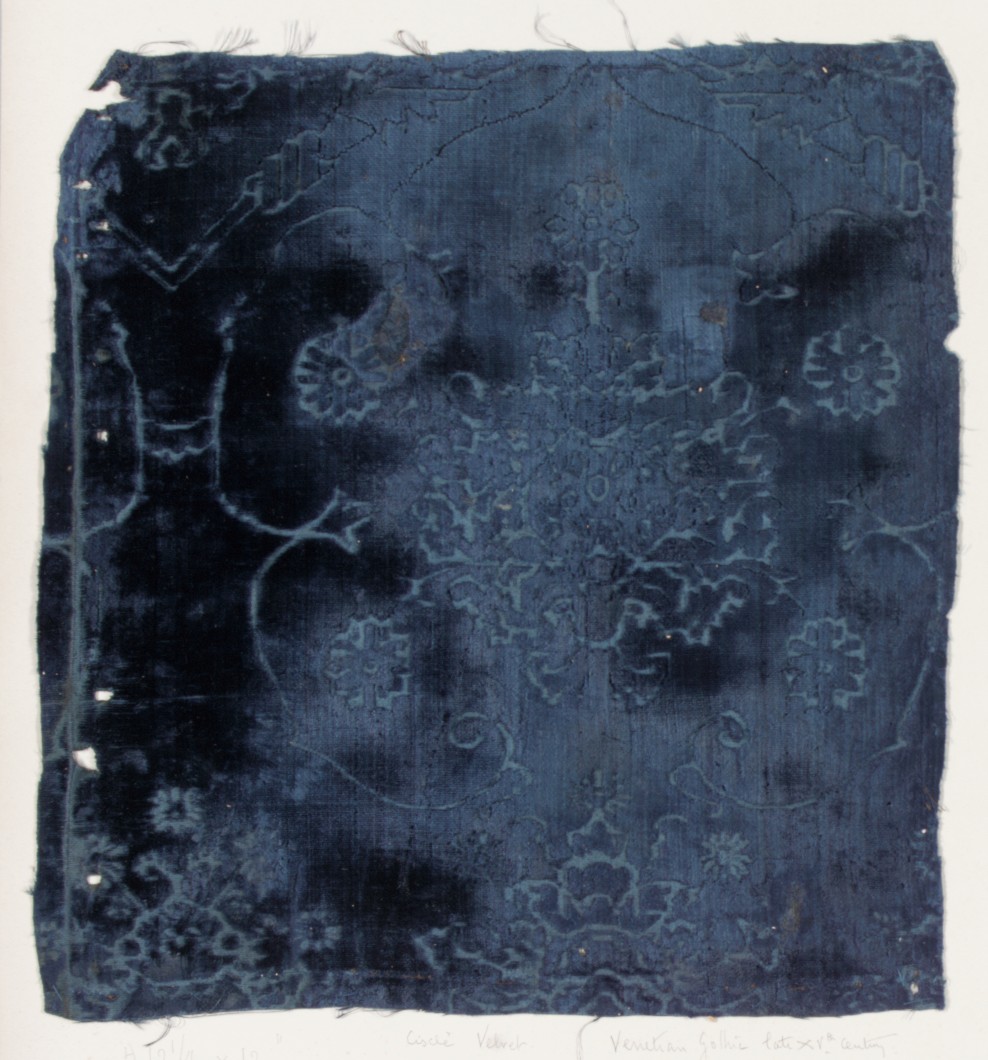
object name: fragment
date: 1467-1500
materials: metal thread, silk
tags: flowers